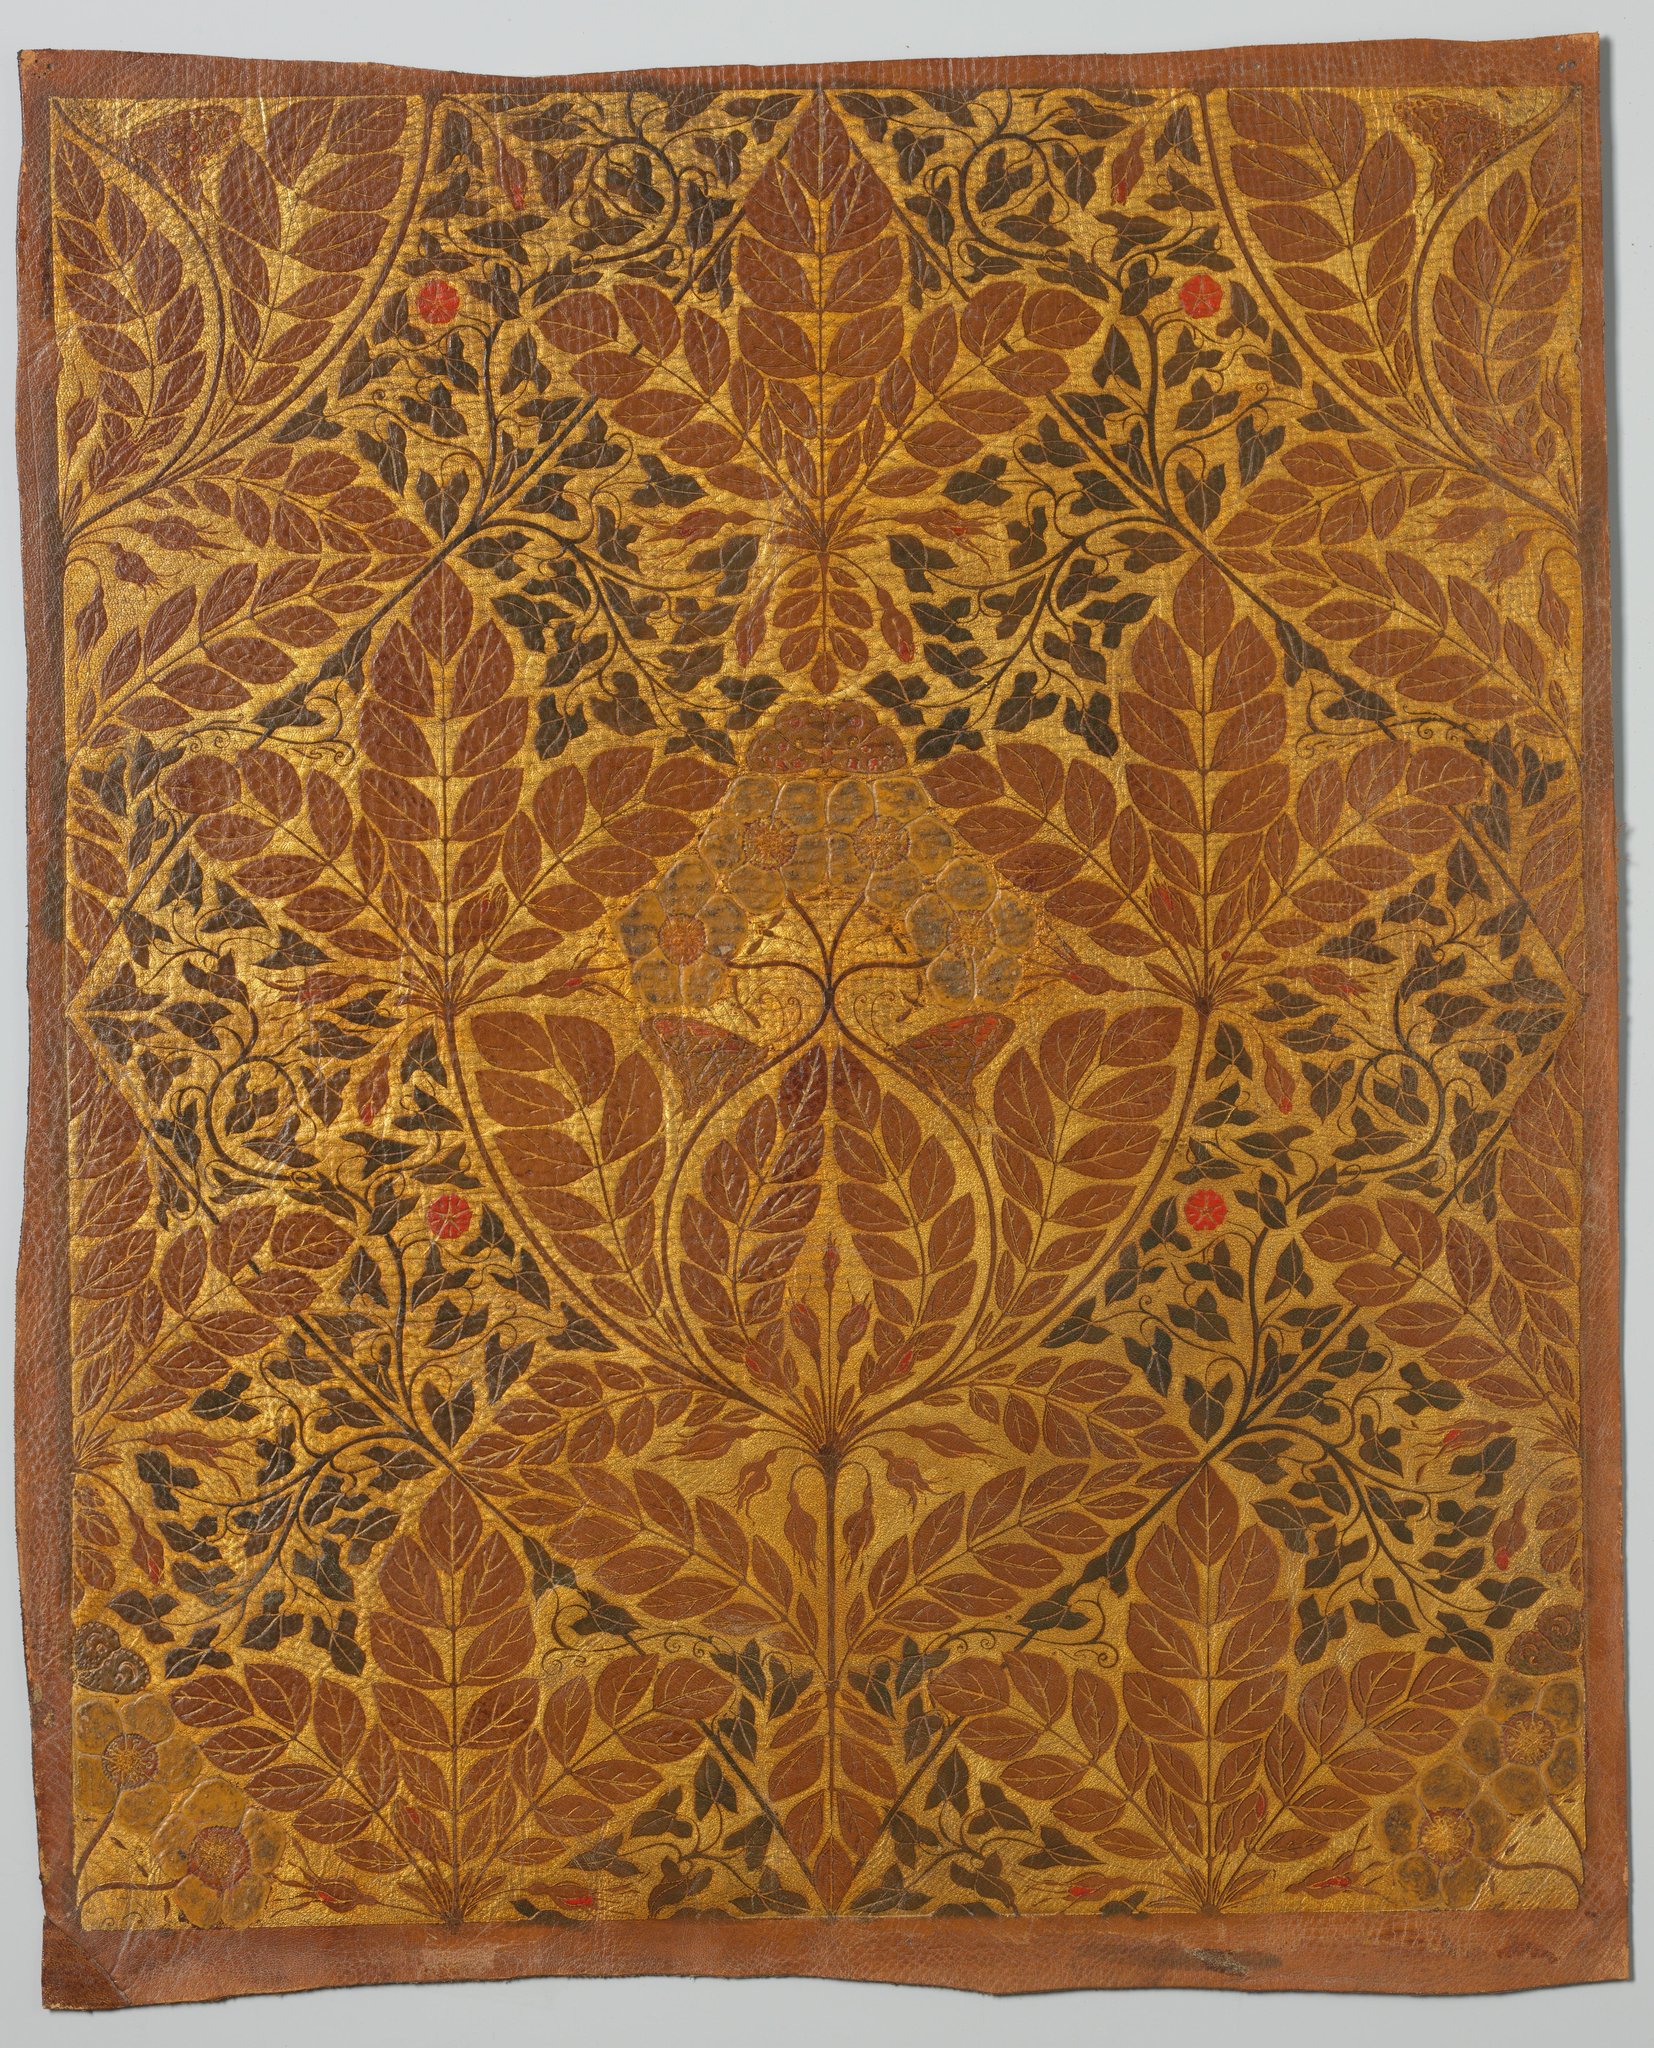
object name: gilt leather hanging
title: Vel van verguld en gepolychromeerd leer, versierd met wilde rozen, ranken en vlinders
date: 1910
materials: leather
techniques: gilding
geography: amsterdam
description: Vel van verguld en gepolychromeerd leer, versierd met wilde rozen, ranken en vlinders, naar ontwerp van Th.W. Nieuwenhuis.